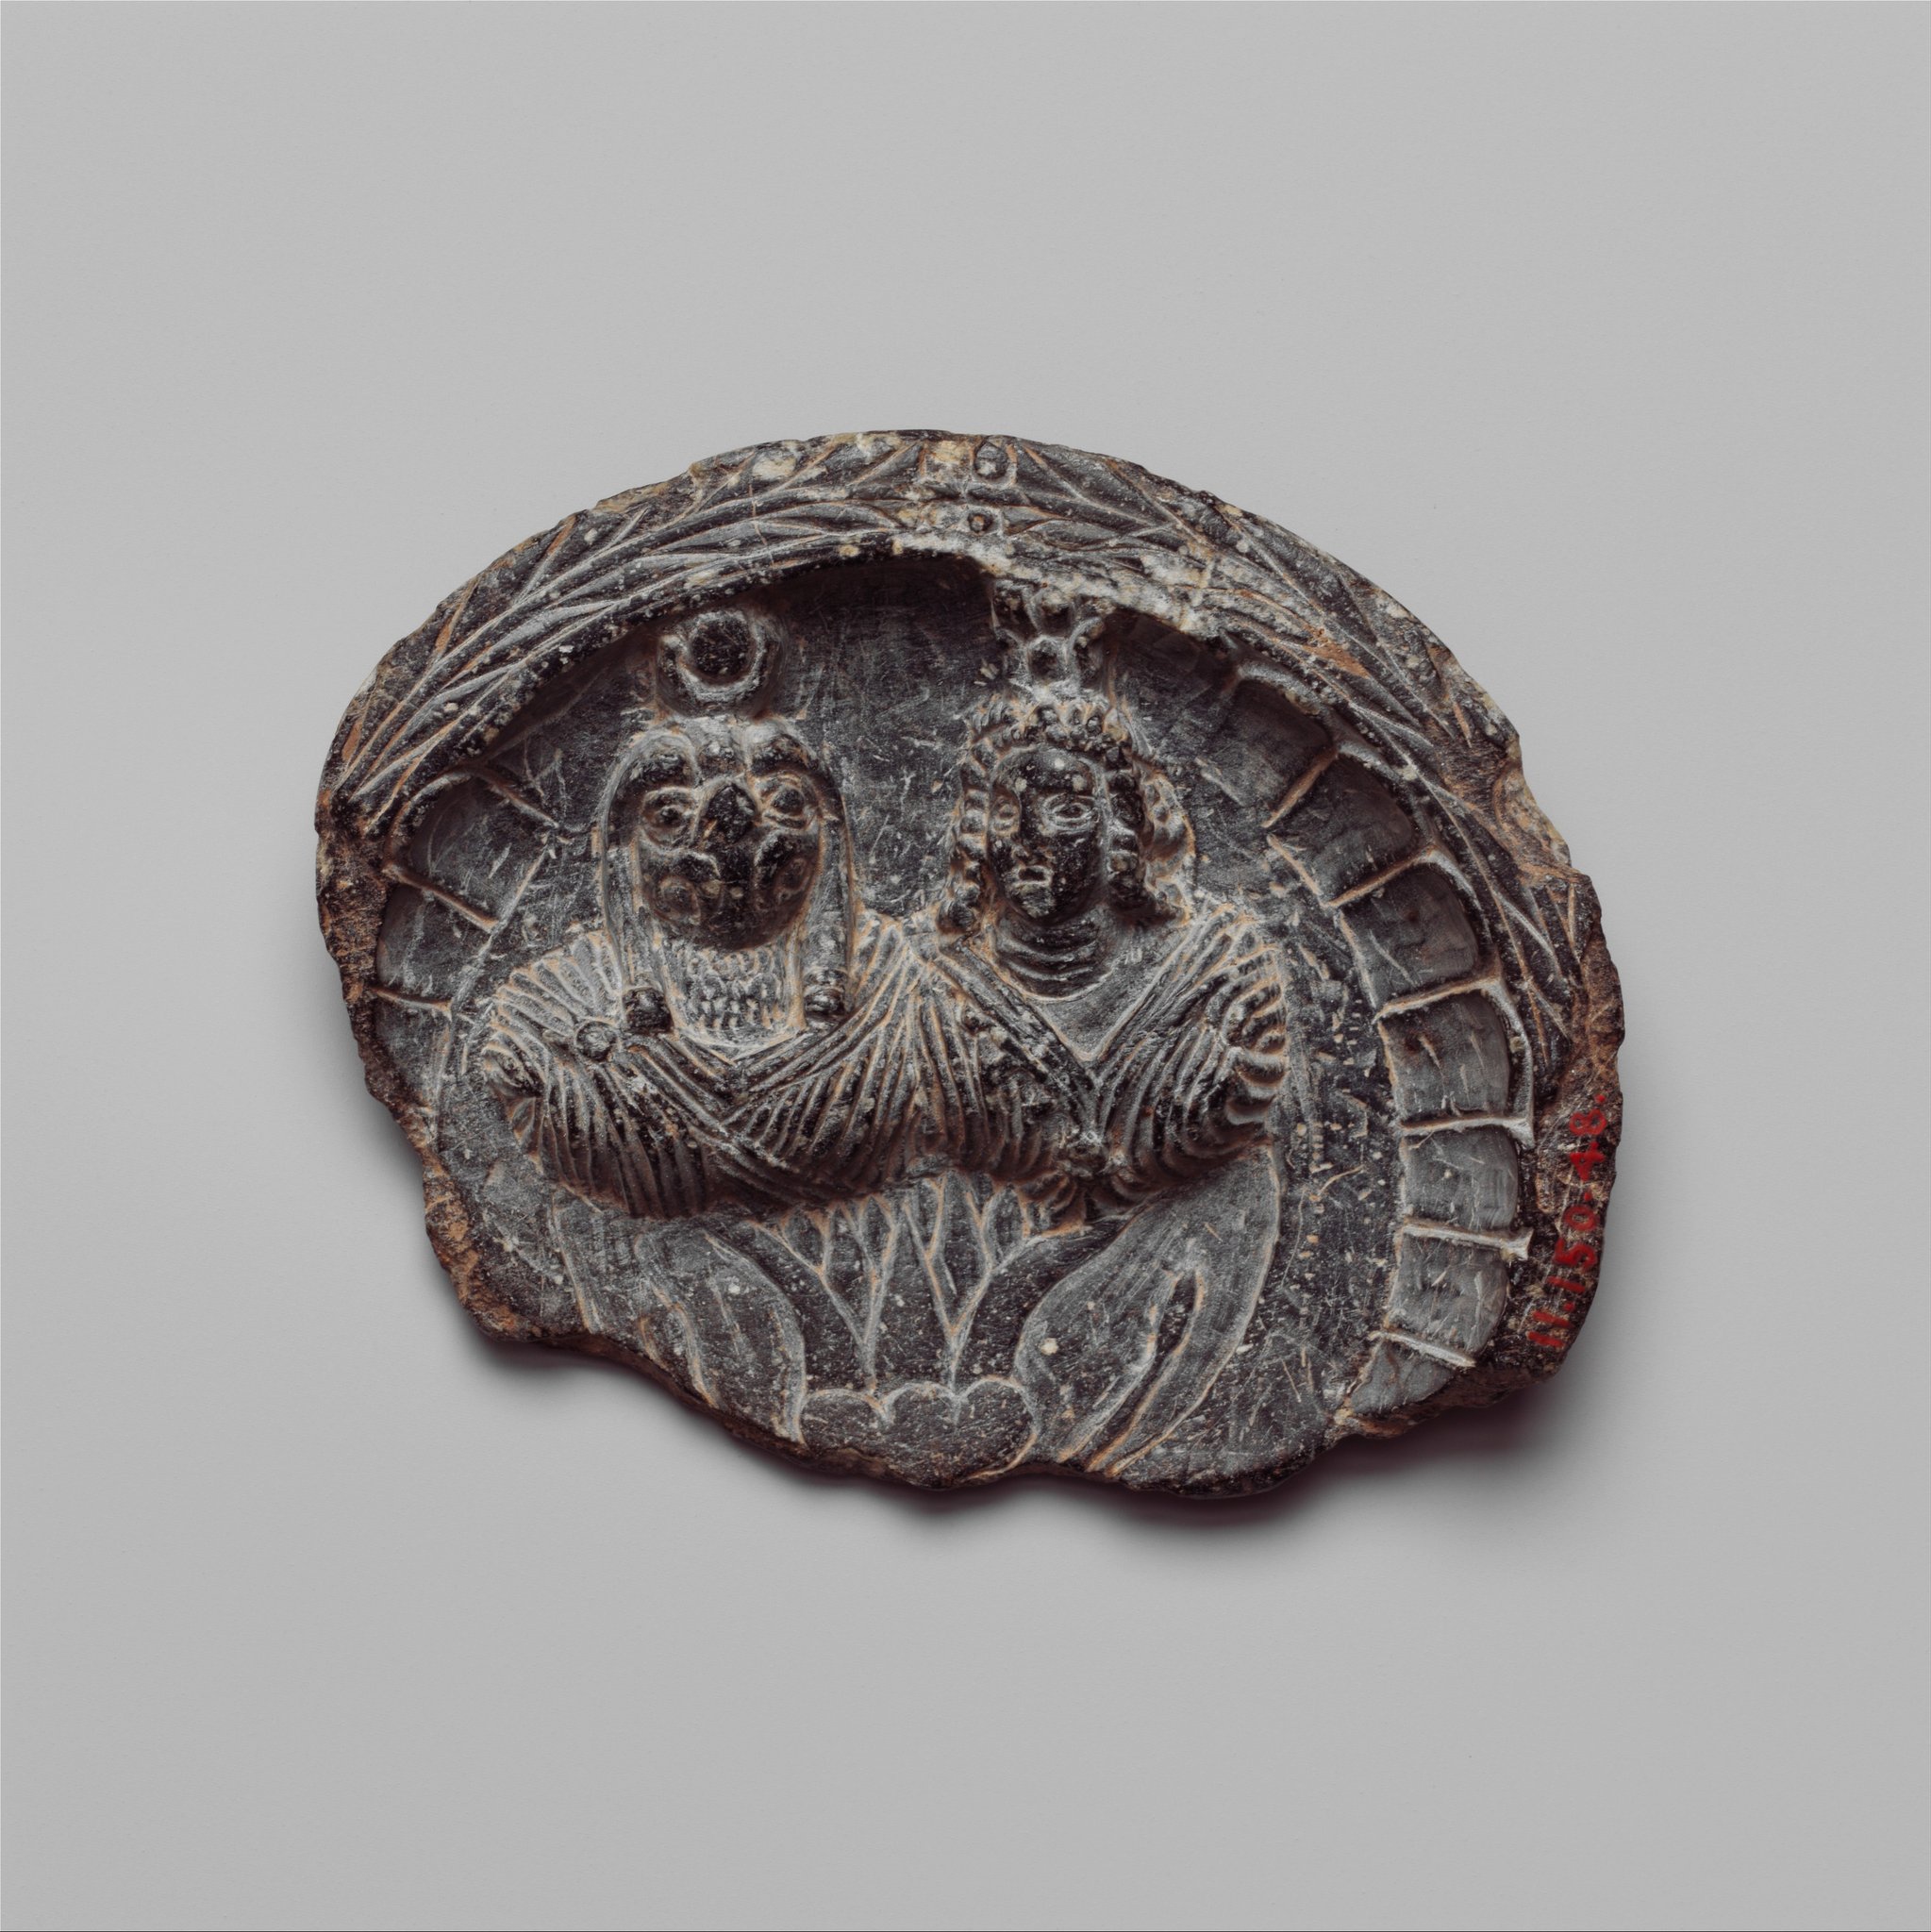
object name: dish, isi and horus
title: Shallow dish with high relief figures of Isis and falcon-headed Horus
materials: stone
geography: egypt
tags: horus,isis